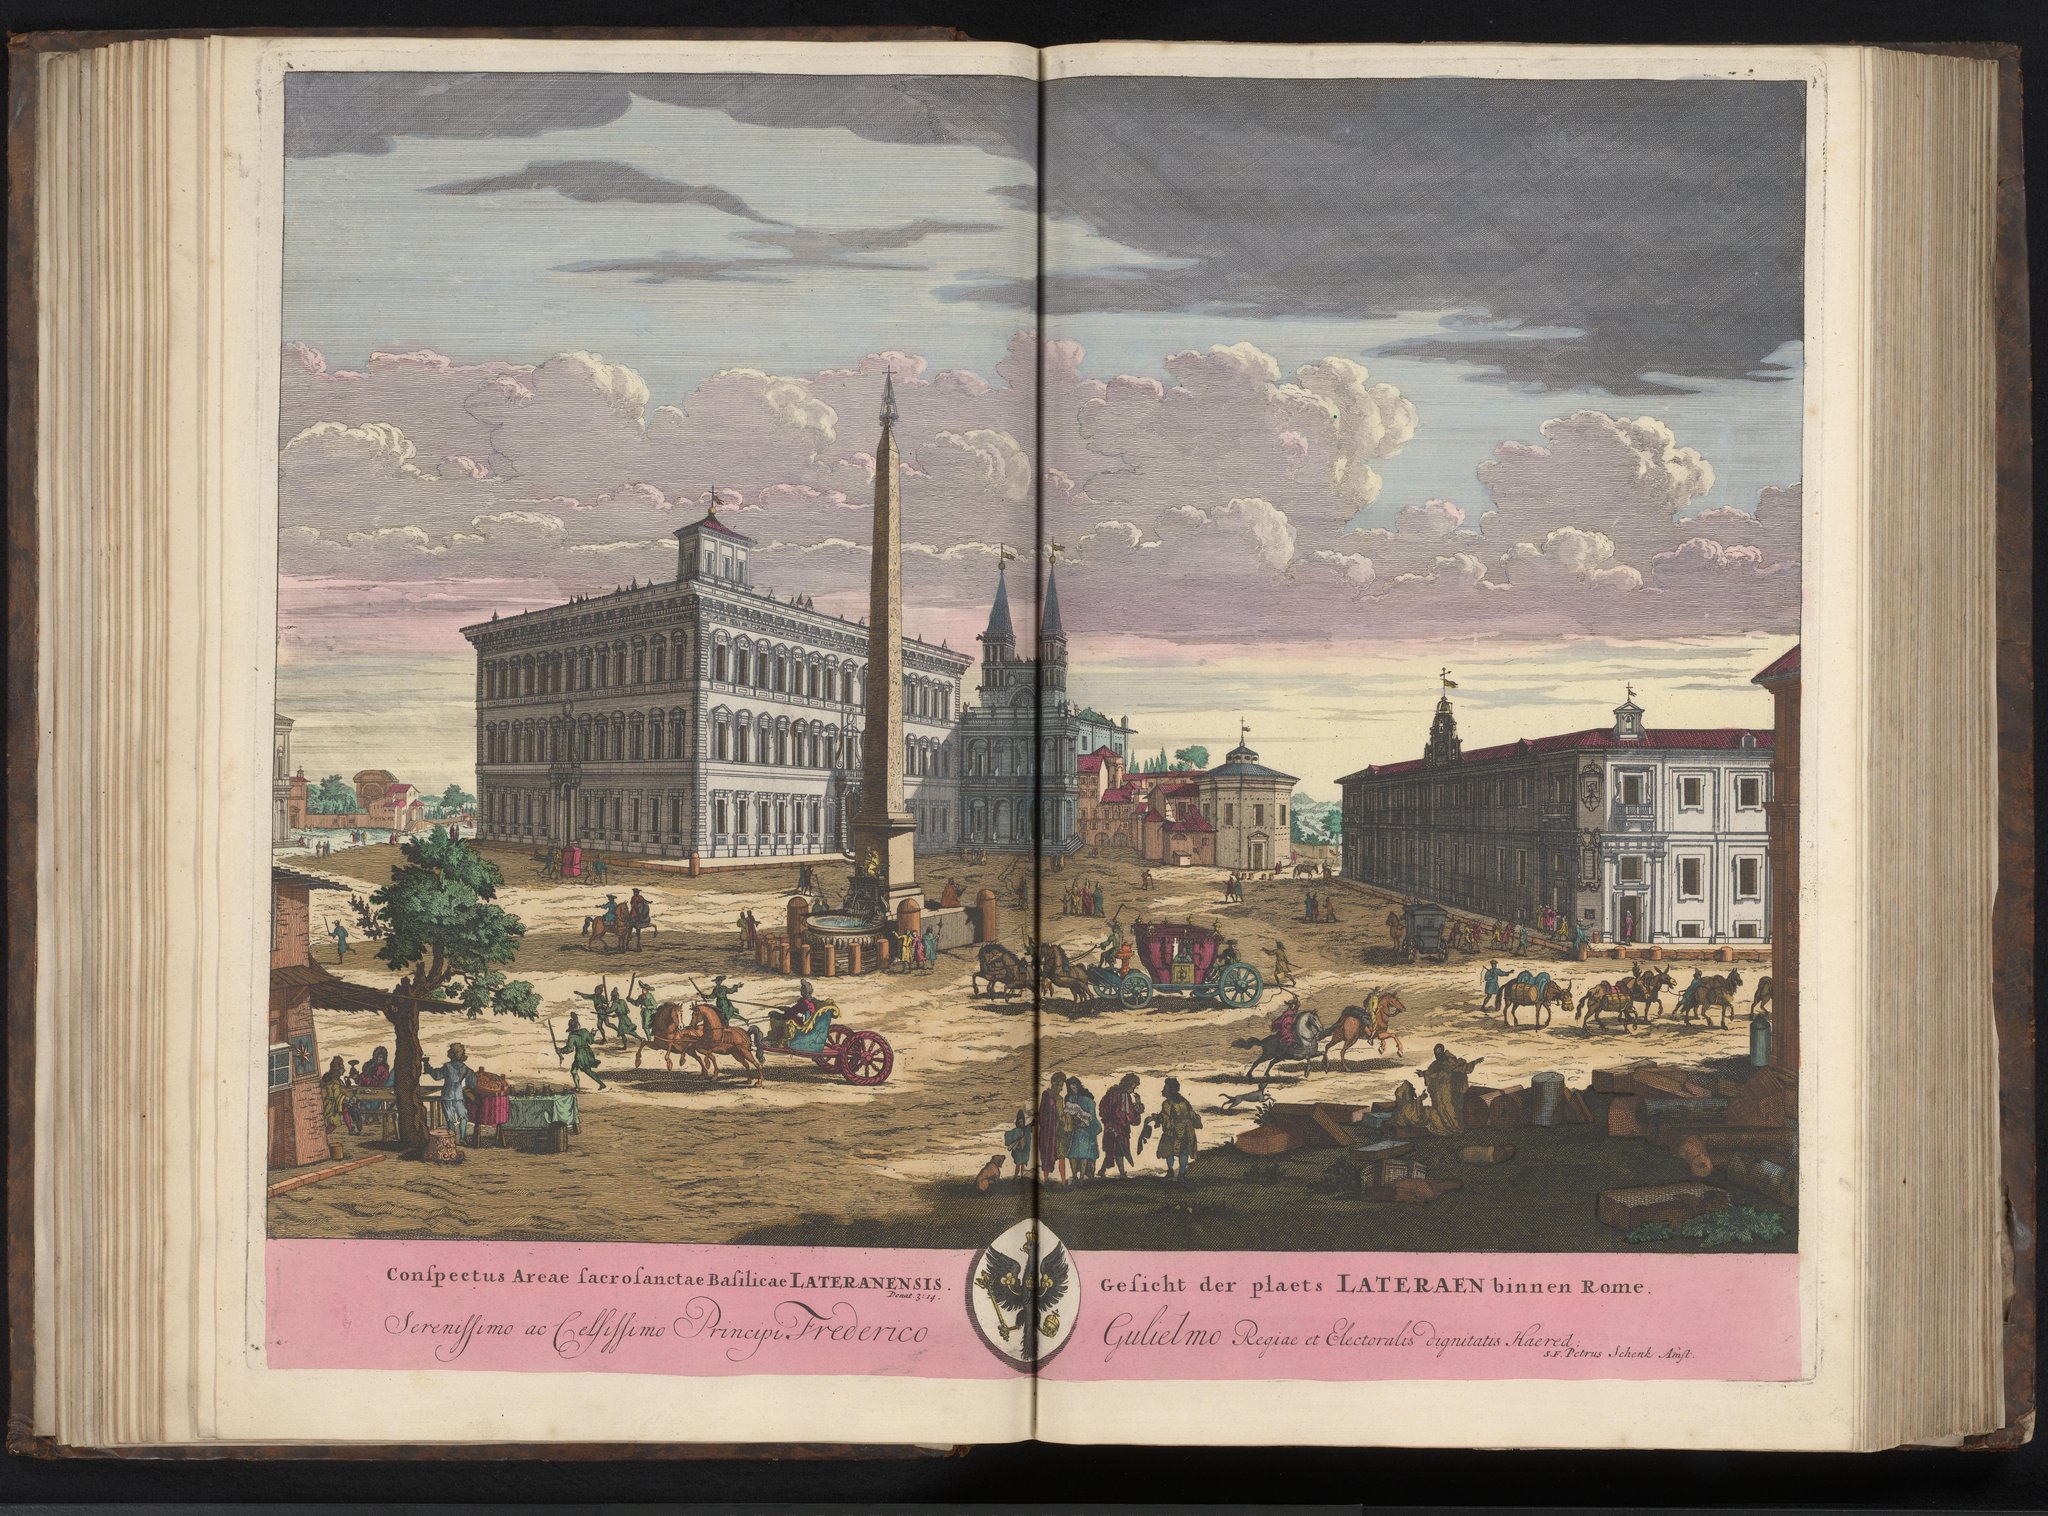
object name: album leaf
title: Gezicht op het Lateraan met de Sint-Jan van Lateranen te Rome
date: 1675-1711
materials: paper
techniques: colour, etching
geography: amsterdam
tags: cardinal, interior of church, pope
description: Gezicht op het Lateraan te Rome, de achterzijde van de basiliek van Sint-Jan van Lateranen, het Baptisterium van Lateranen, het Lateraans Paleis en de Lateraanse Obelisk. In de ondermarge de titel in het Latijn en het Duits. Prent maakt deel uit van een album.